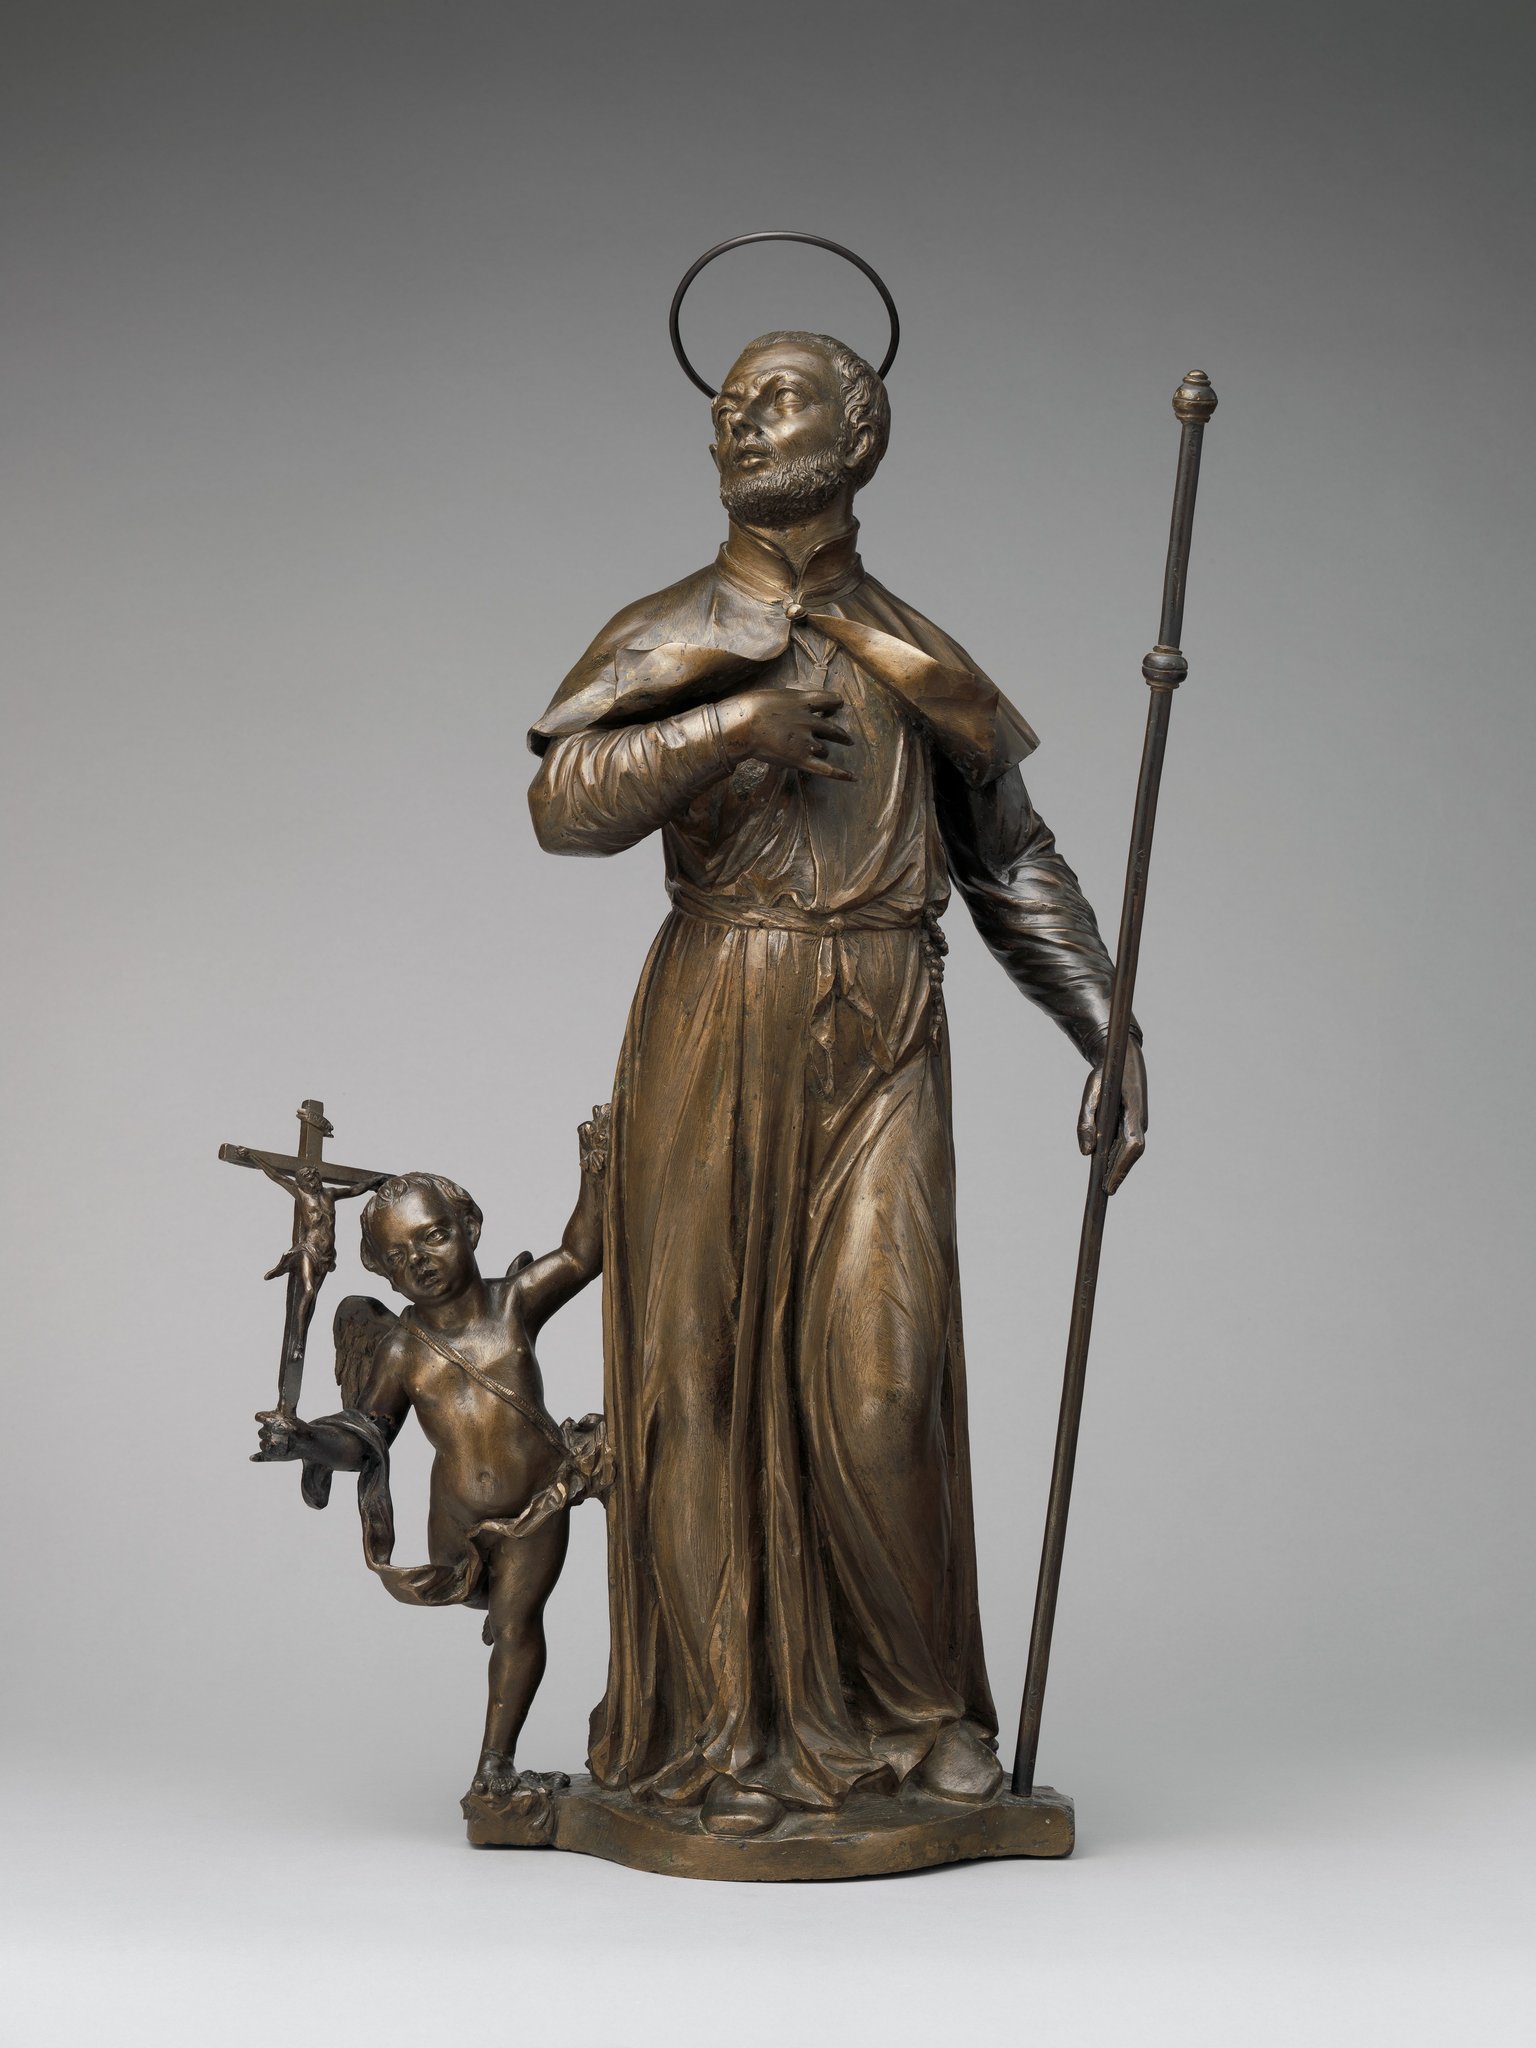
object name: statue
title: Saint Francis Xavier with an angel holding a crucifix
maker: francesco bertos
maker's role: maker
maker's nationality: italian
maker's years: 1678-1741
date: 1722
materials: bronze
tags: angels,cross,saints